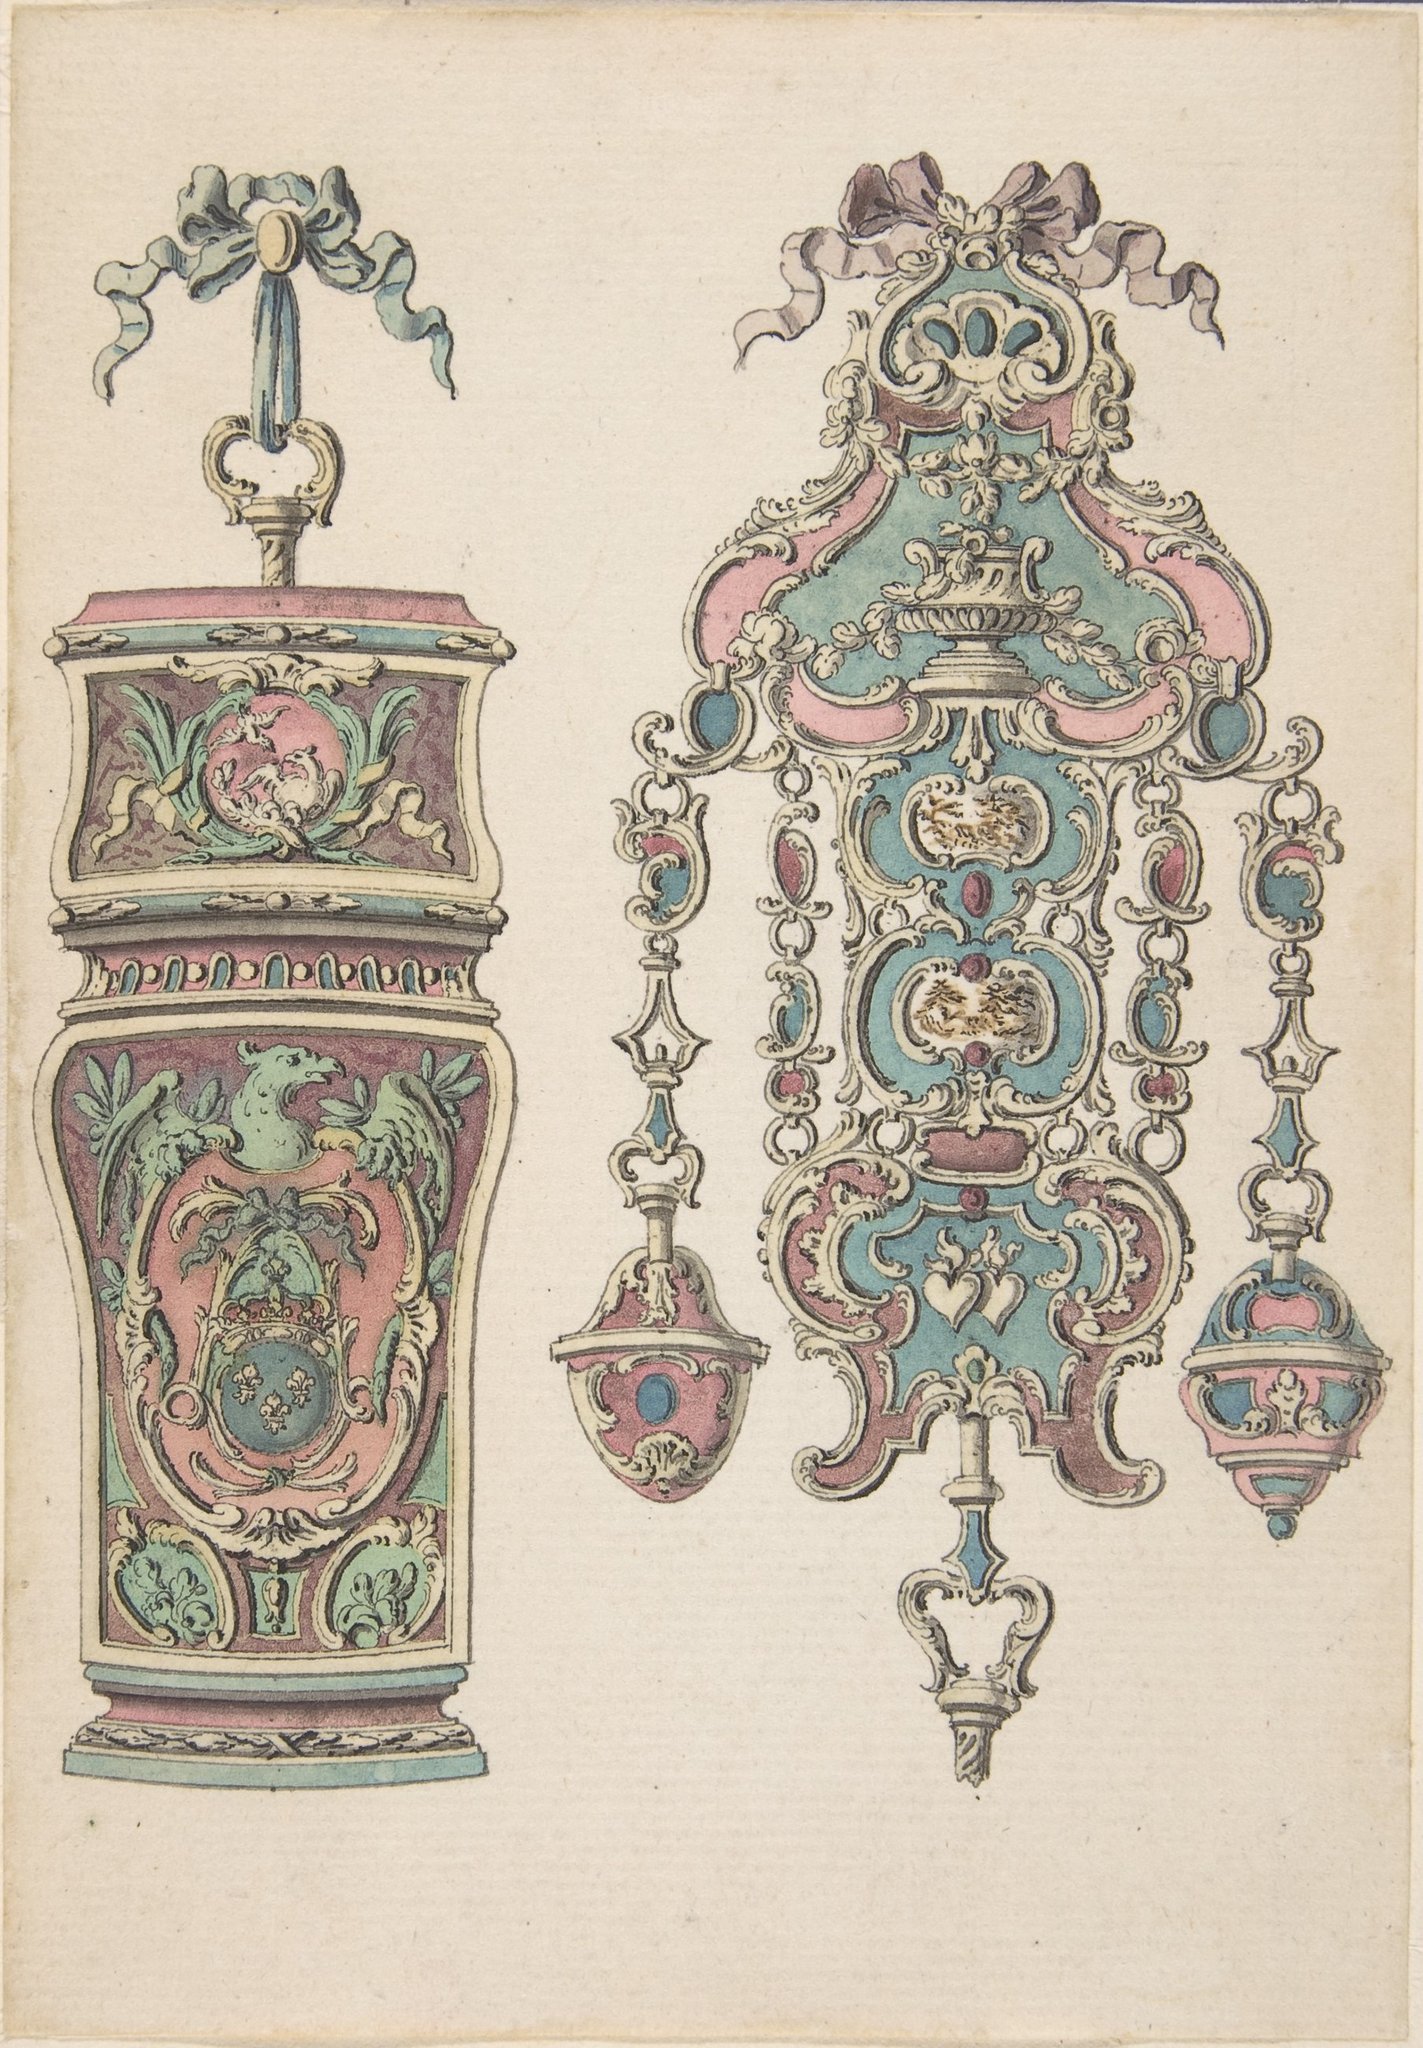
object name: drawing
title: Designs for an Etui and a Chatelaine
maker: pierre moreau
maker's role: artist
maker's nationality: french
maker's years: 1715-1798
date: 1750-1777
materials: ink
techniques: brush, pen, wash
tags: jewelry